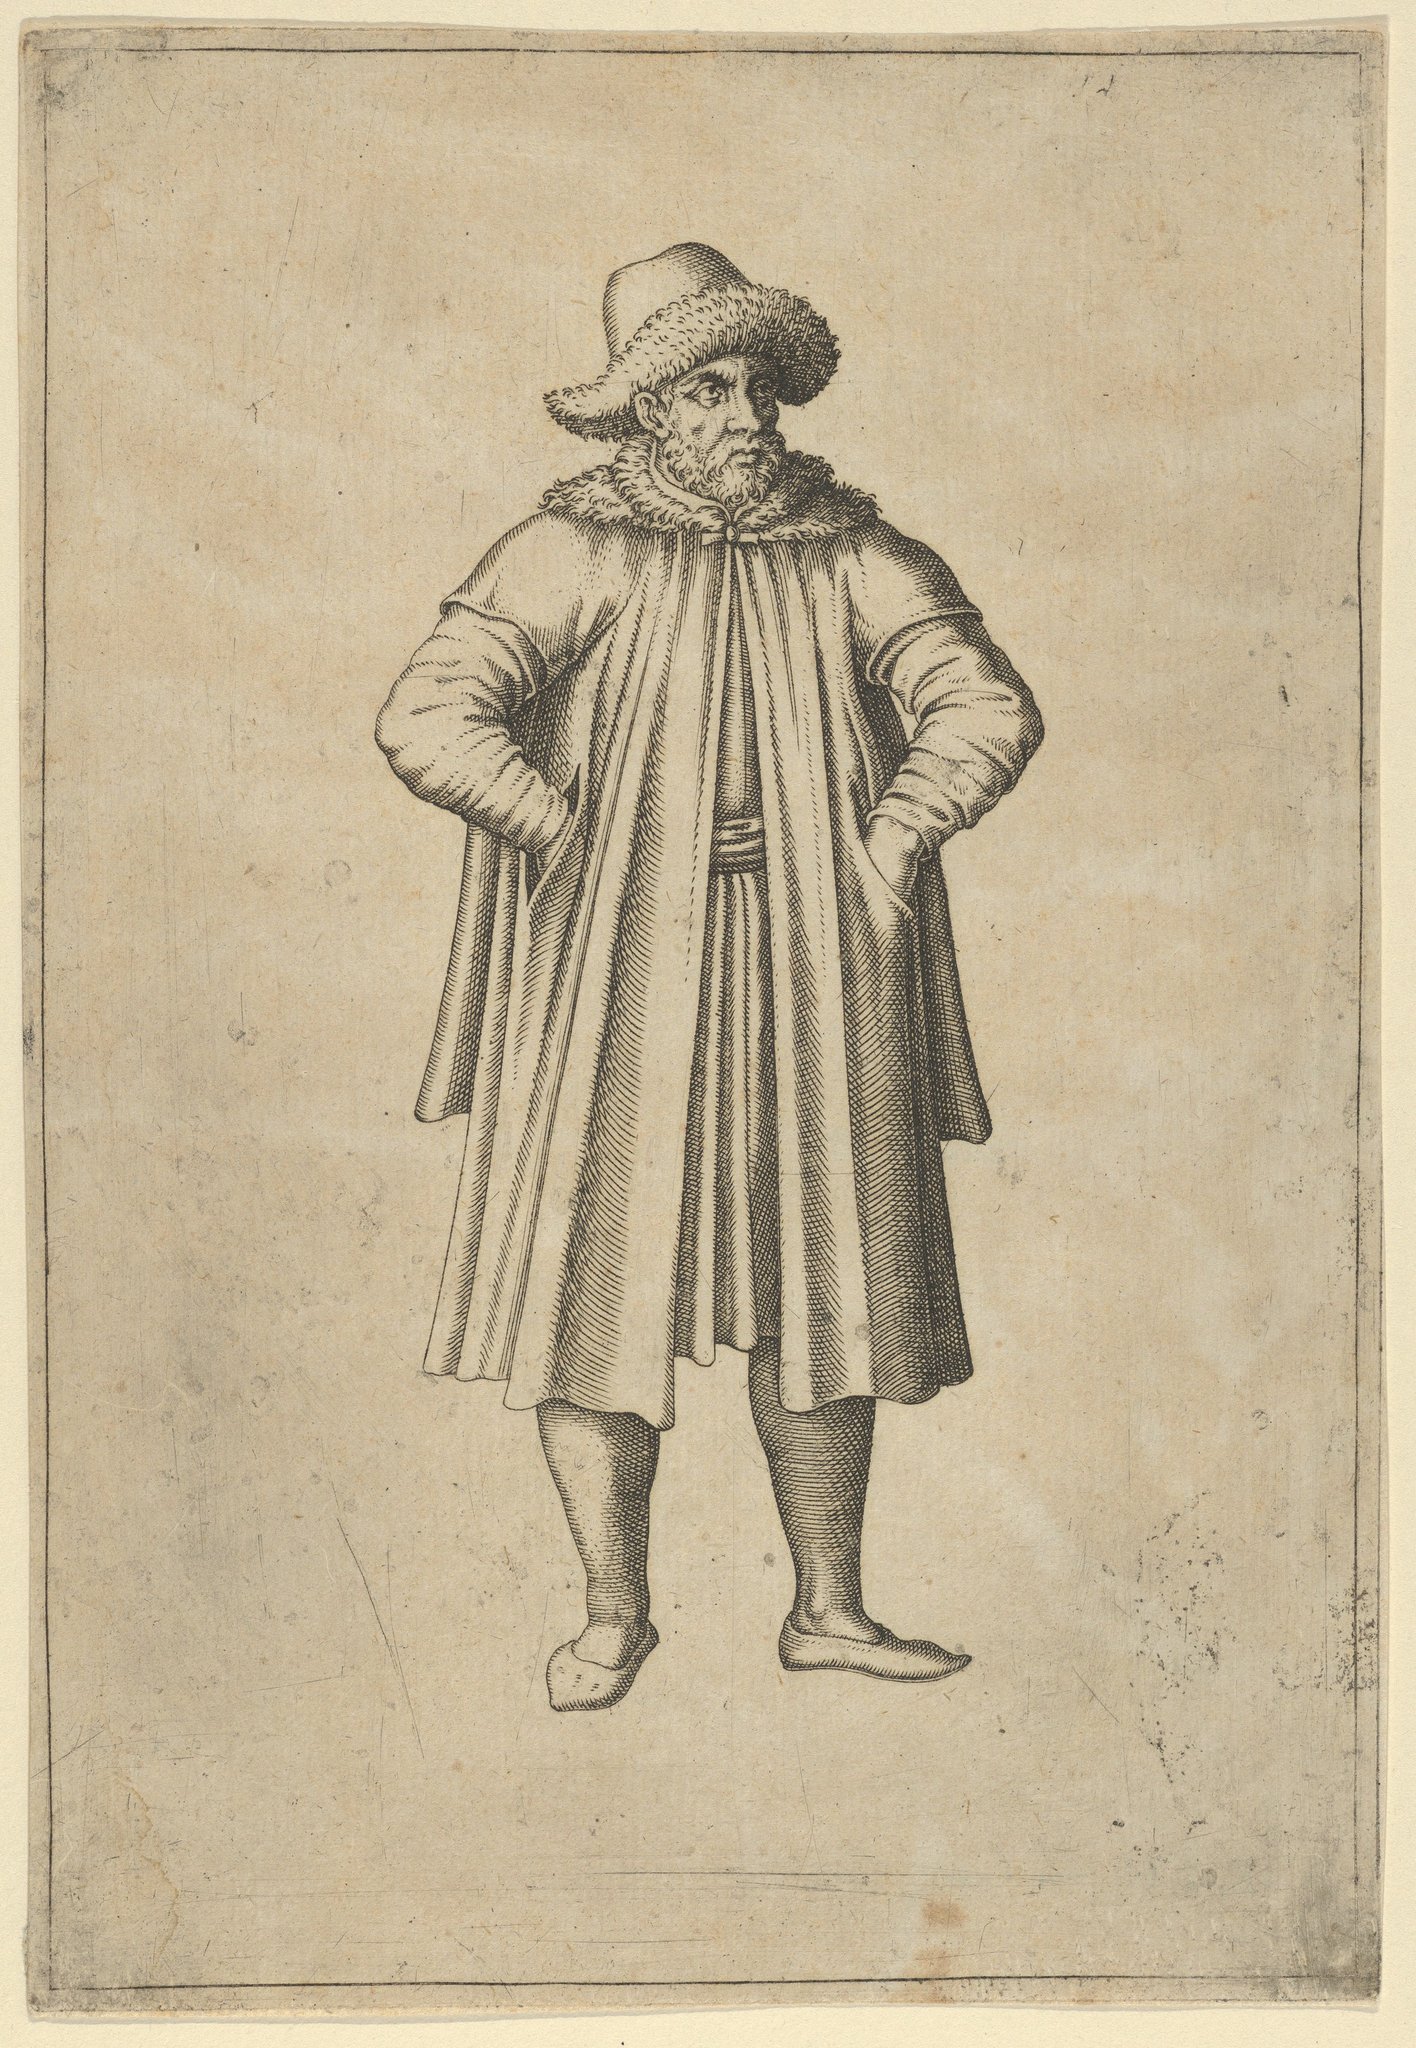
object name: print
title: Ragusej Merchant, from "Les quatre premiers livres des navigations et pérégrinations orientales" by Nicolas de Nicolay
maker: Anonymous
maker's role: artist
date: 1568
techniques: etching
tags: men,portraits,merchants